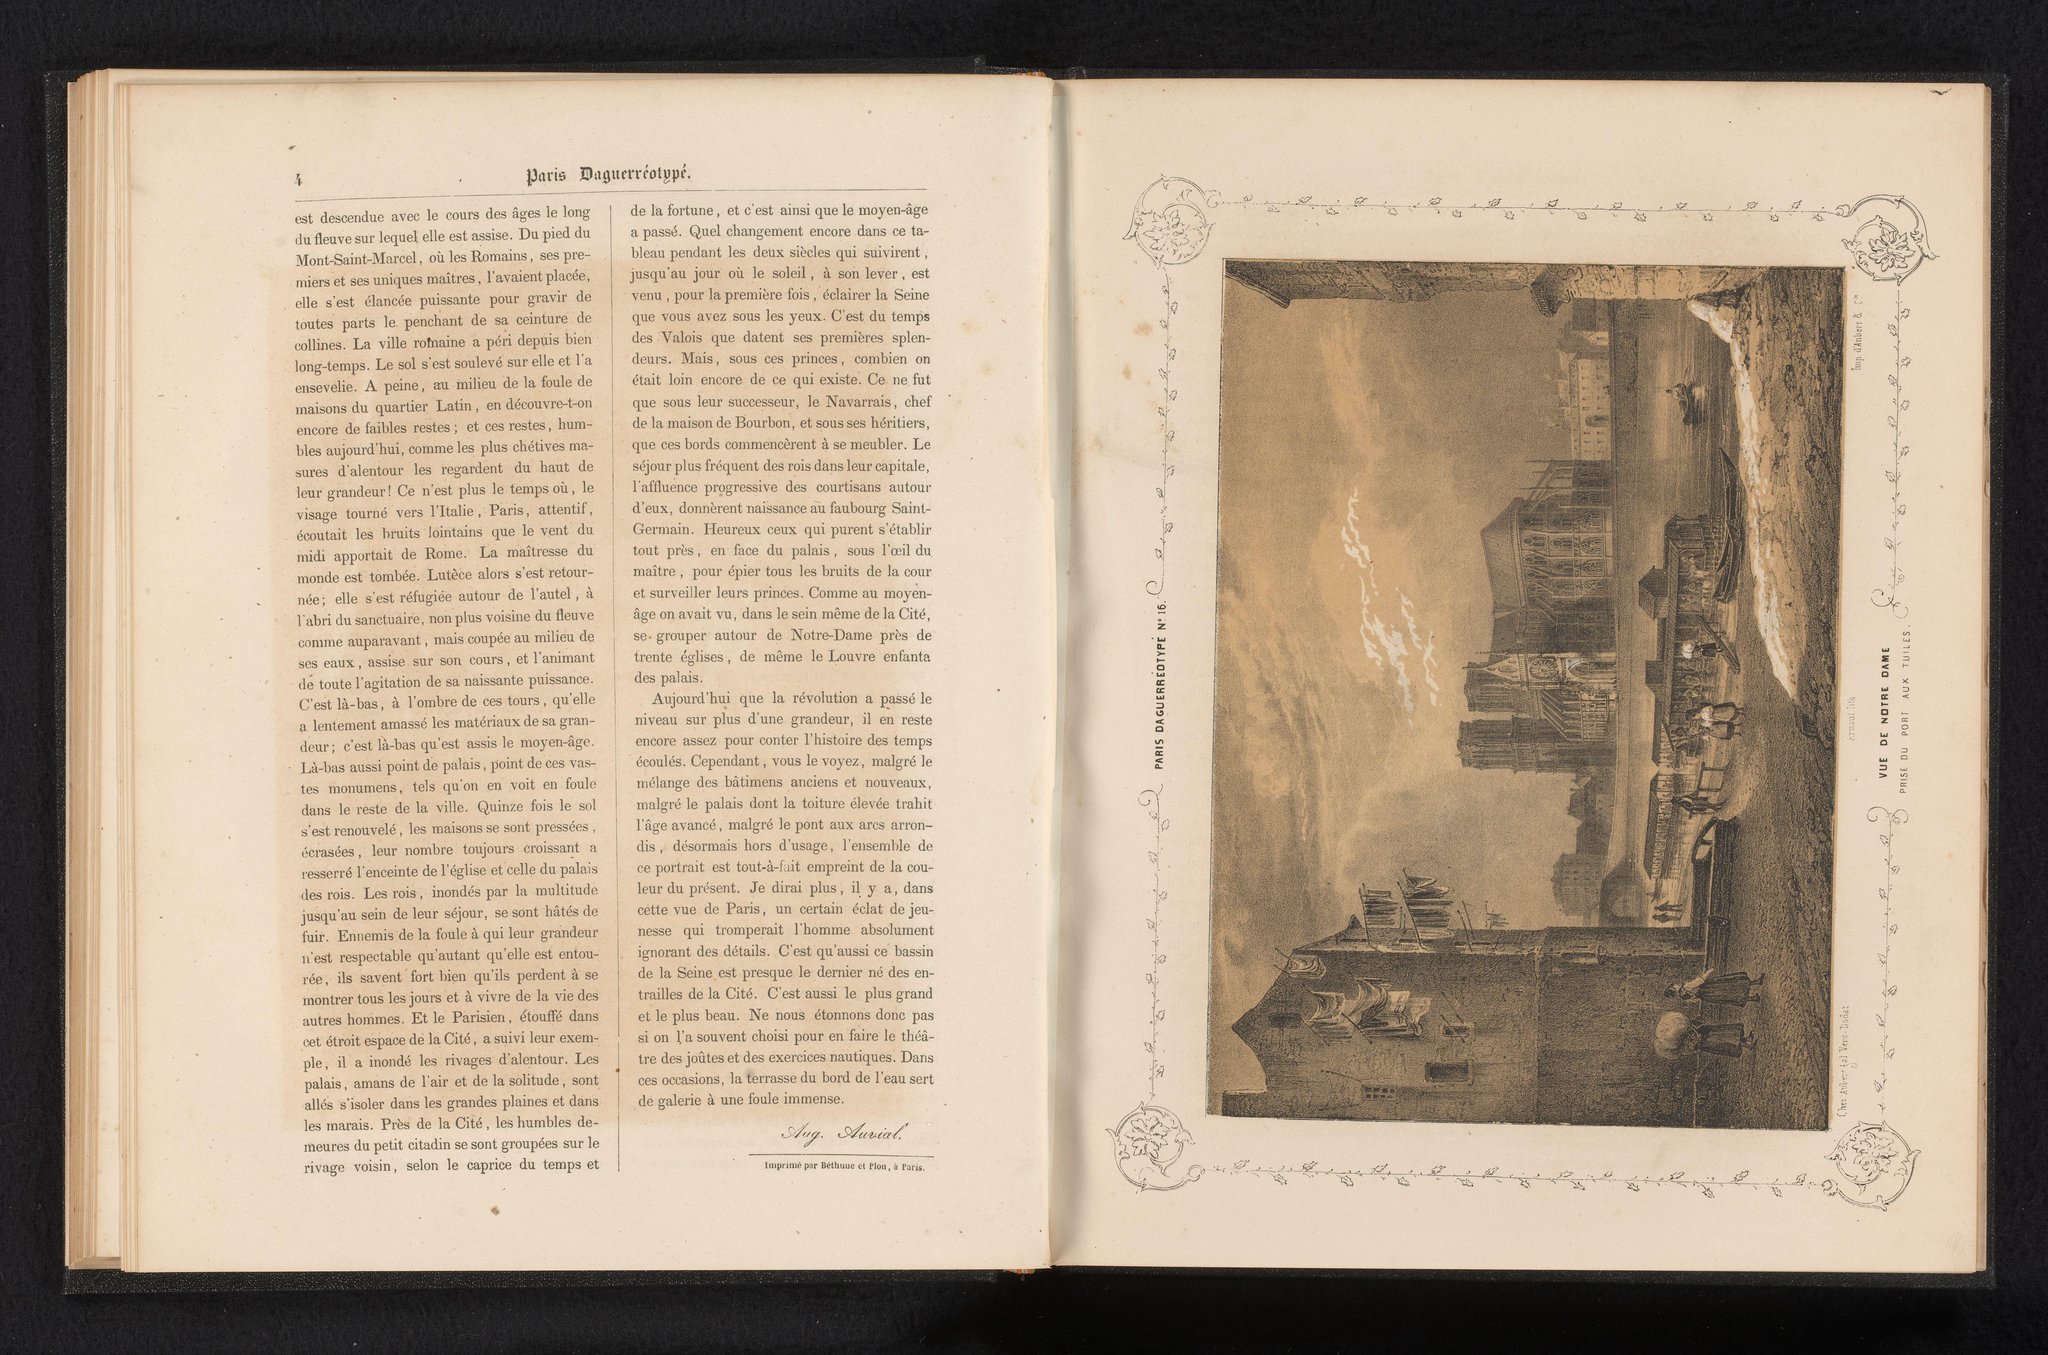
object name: page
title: Gezicht op de Notre-Dame van Parijs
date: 1839-1840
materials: paper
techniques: tone lithography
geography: paris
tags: church (exterior)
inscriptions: inscription: ‘PARIS DAGUERRÉOTYPÉ No. 16.’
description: Prent op eenenzestigste ongenummerde pagina.